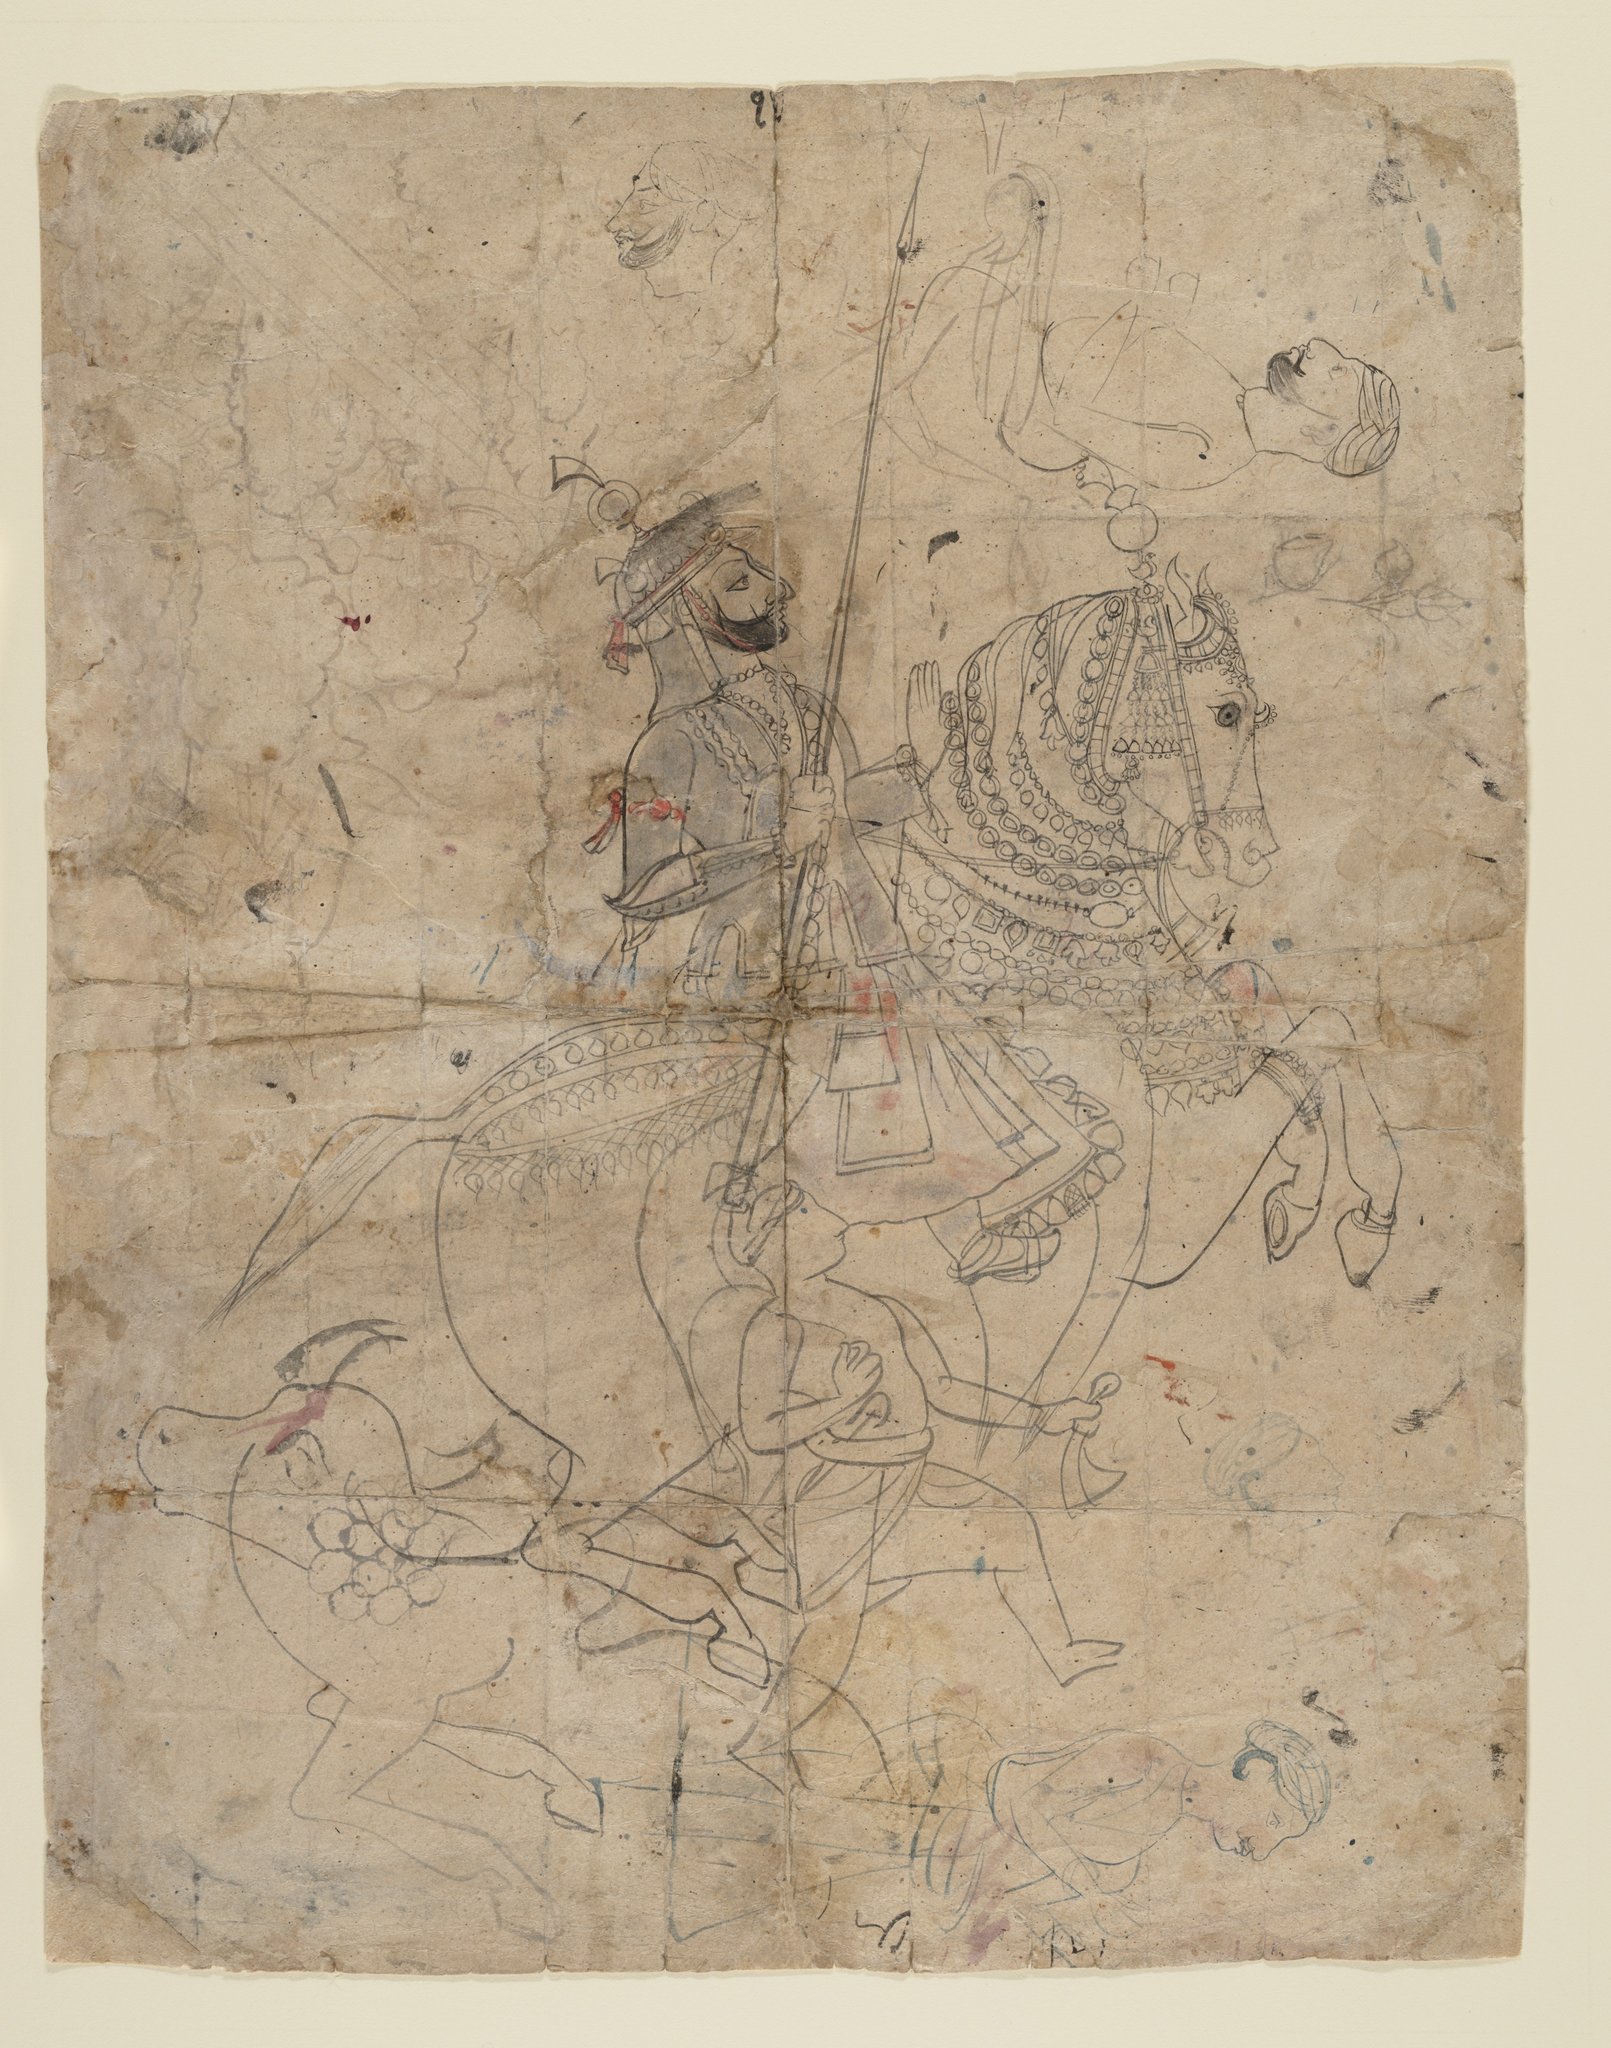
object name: painting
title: Worship of Brijnathji and Svamini (recto); Equestrian Portrait (verso)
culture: indian or rajasthan or kotah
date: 1800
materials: ink, paper, watercolor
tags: men,horses